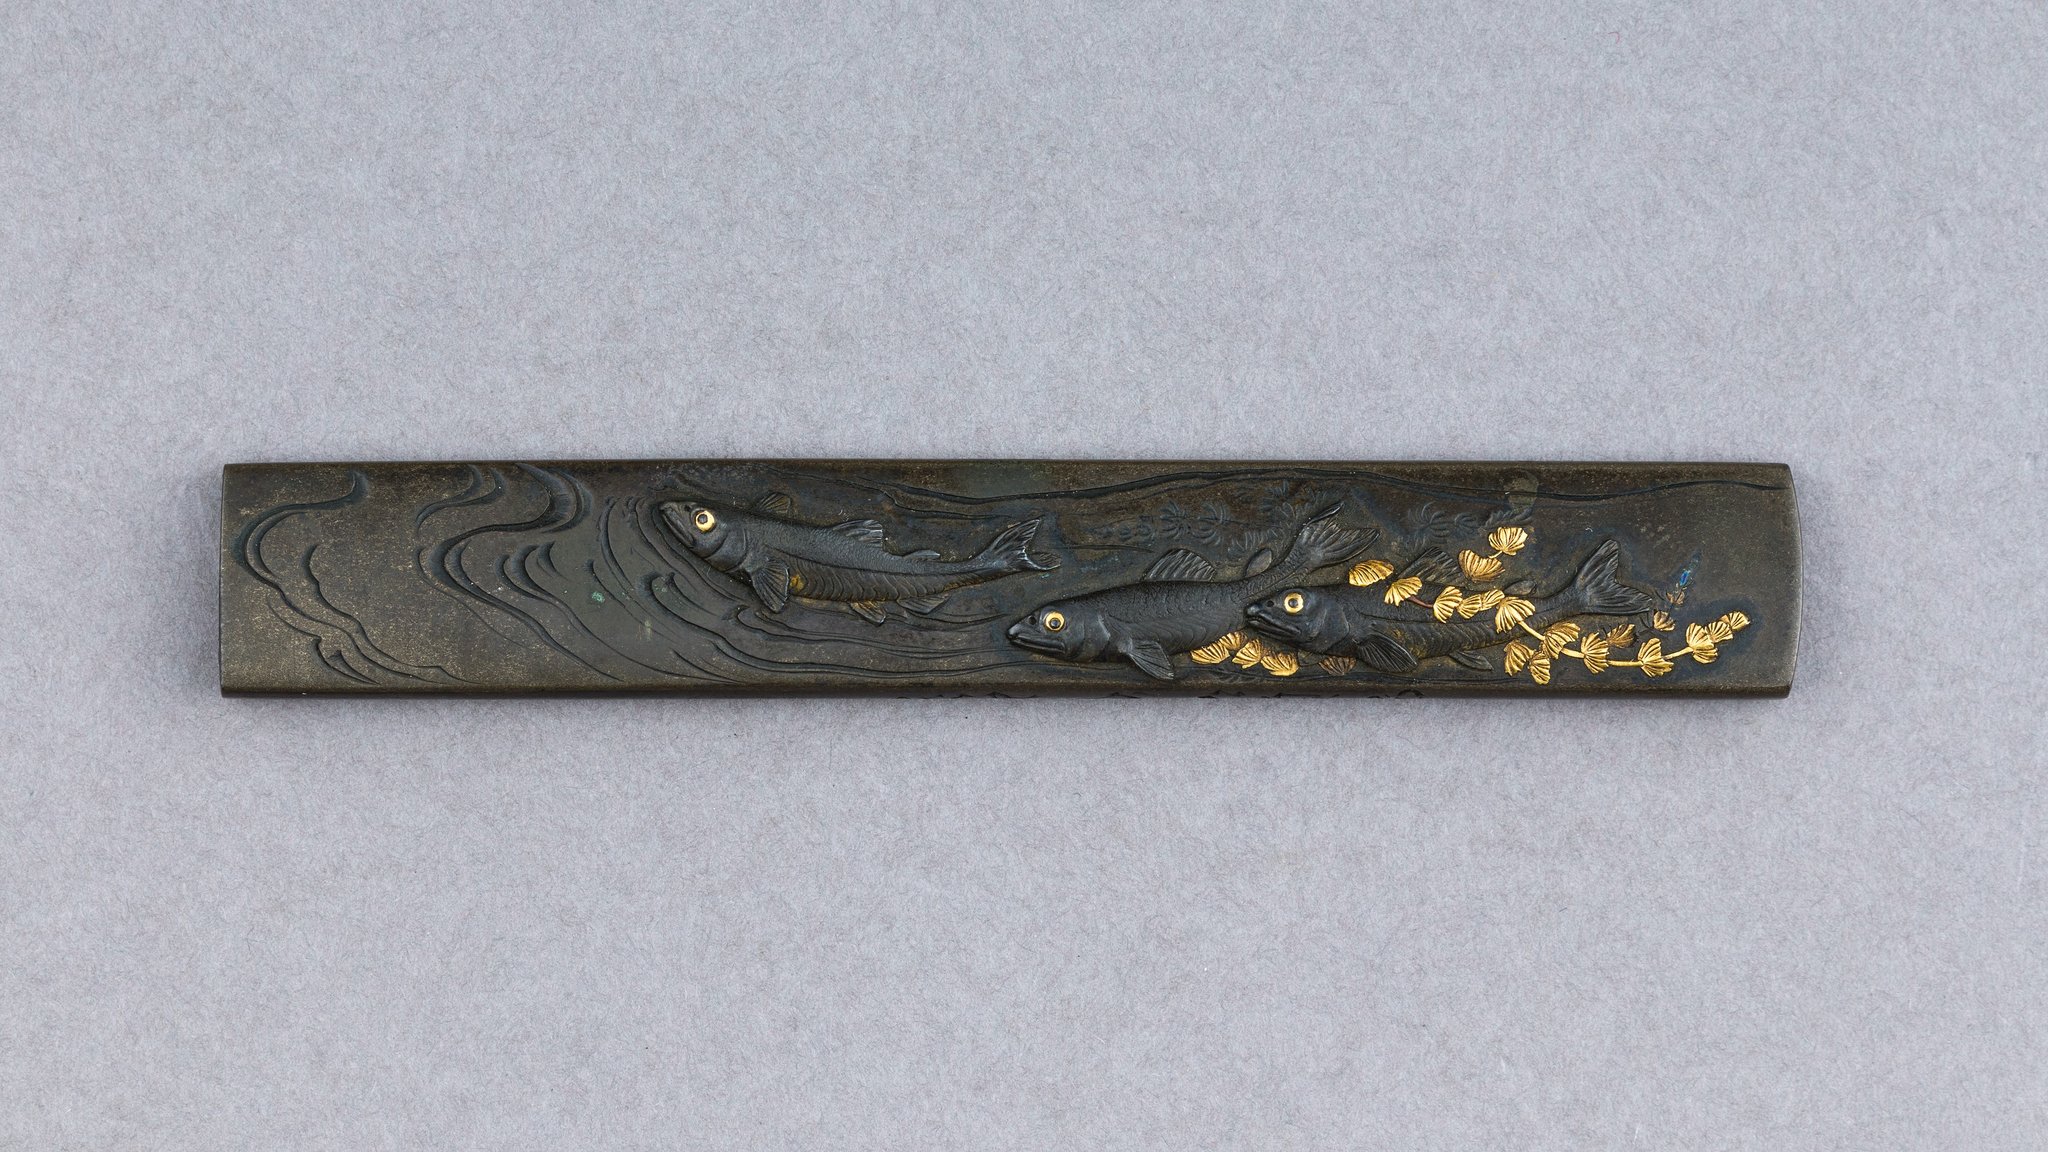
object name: knife handle kozuka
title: Knife Handle (Kozuka)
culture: japanese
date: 1615-1868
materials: silver alloy, gold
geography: japan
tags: fish